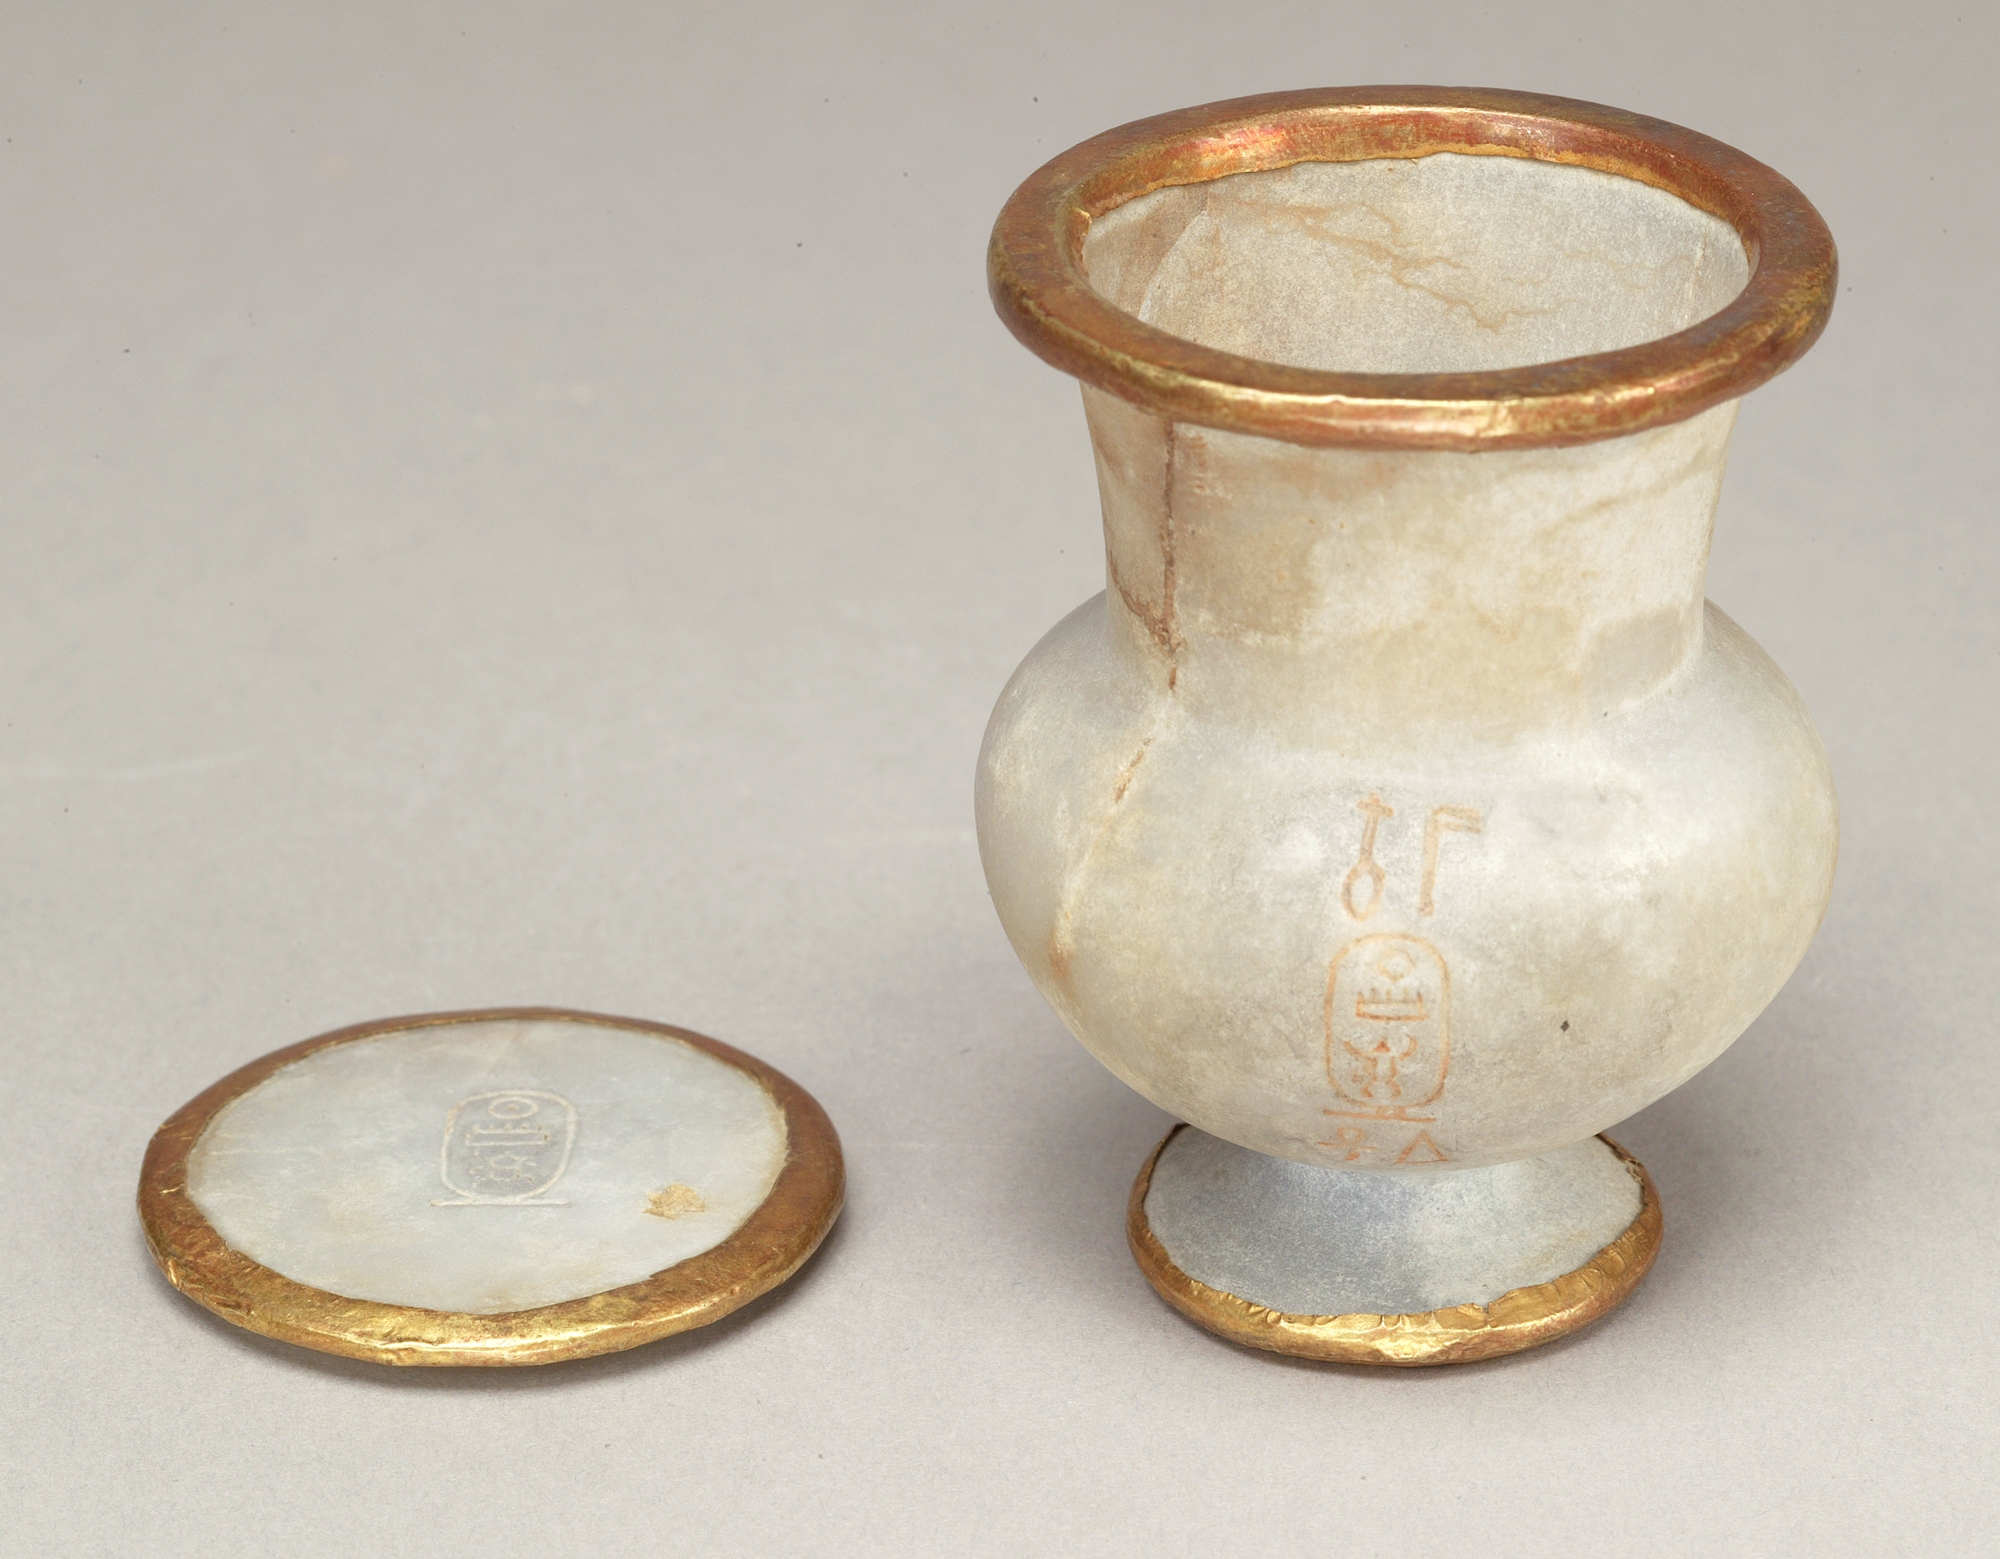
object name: jar, wide necked, inscribed for thutmose iii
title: Wide-necked jar and lid naming Thutmose III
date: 1479-1425 BCE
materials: gold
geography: egypt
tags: hieroglyphs